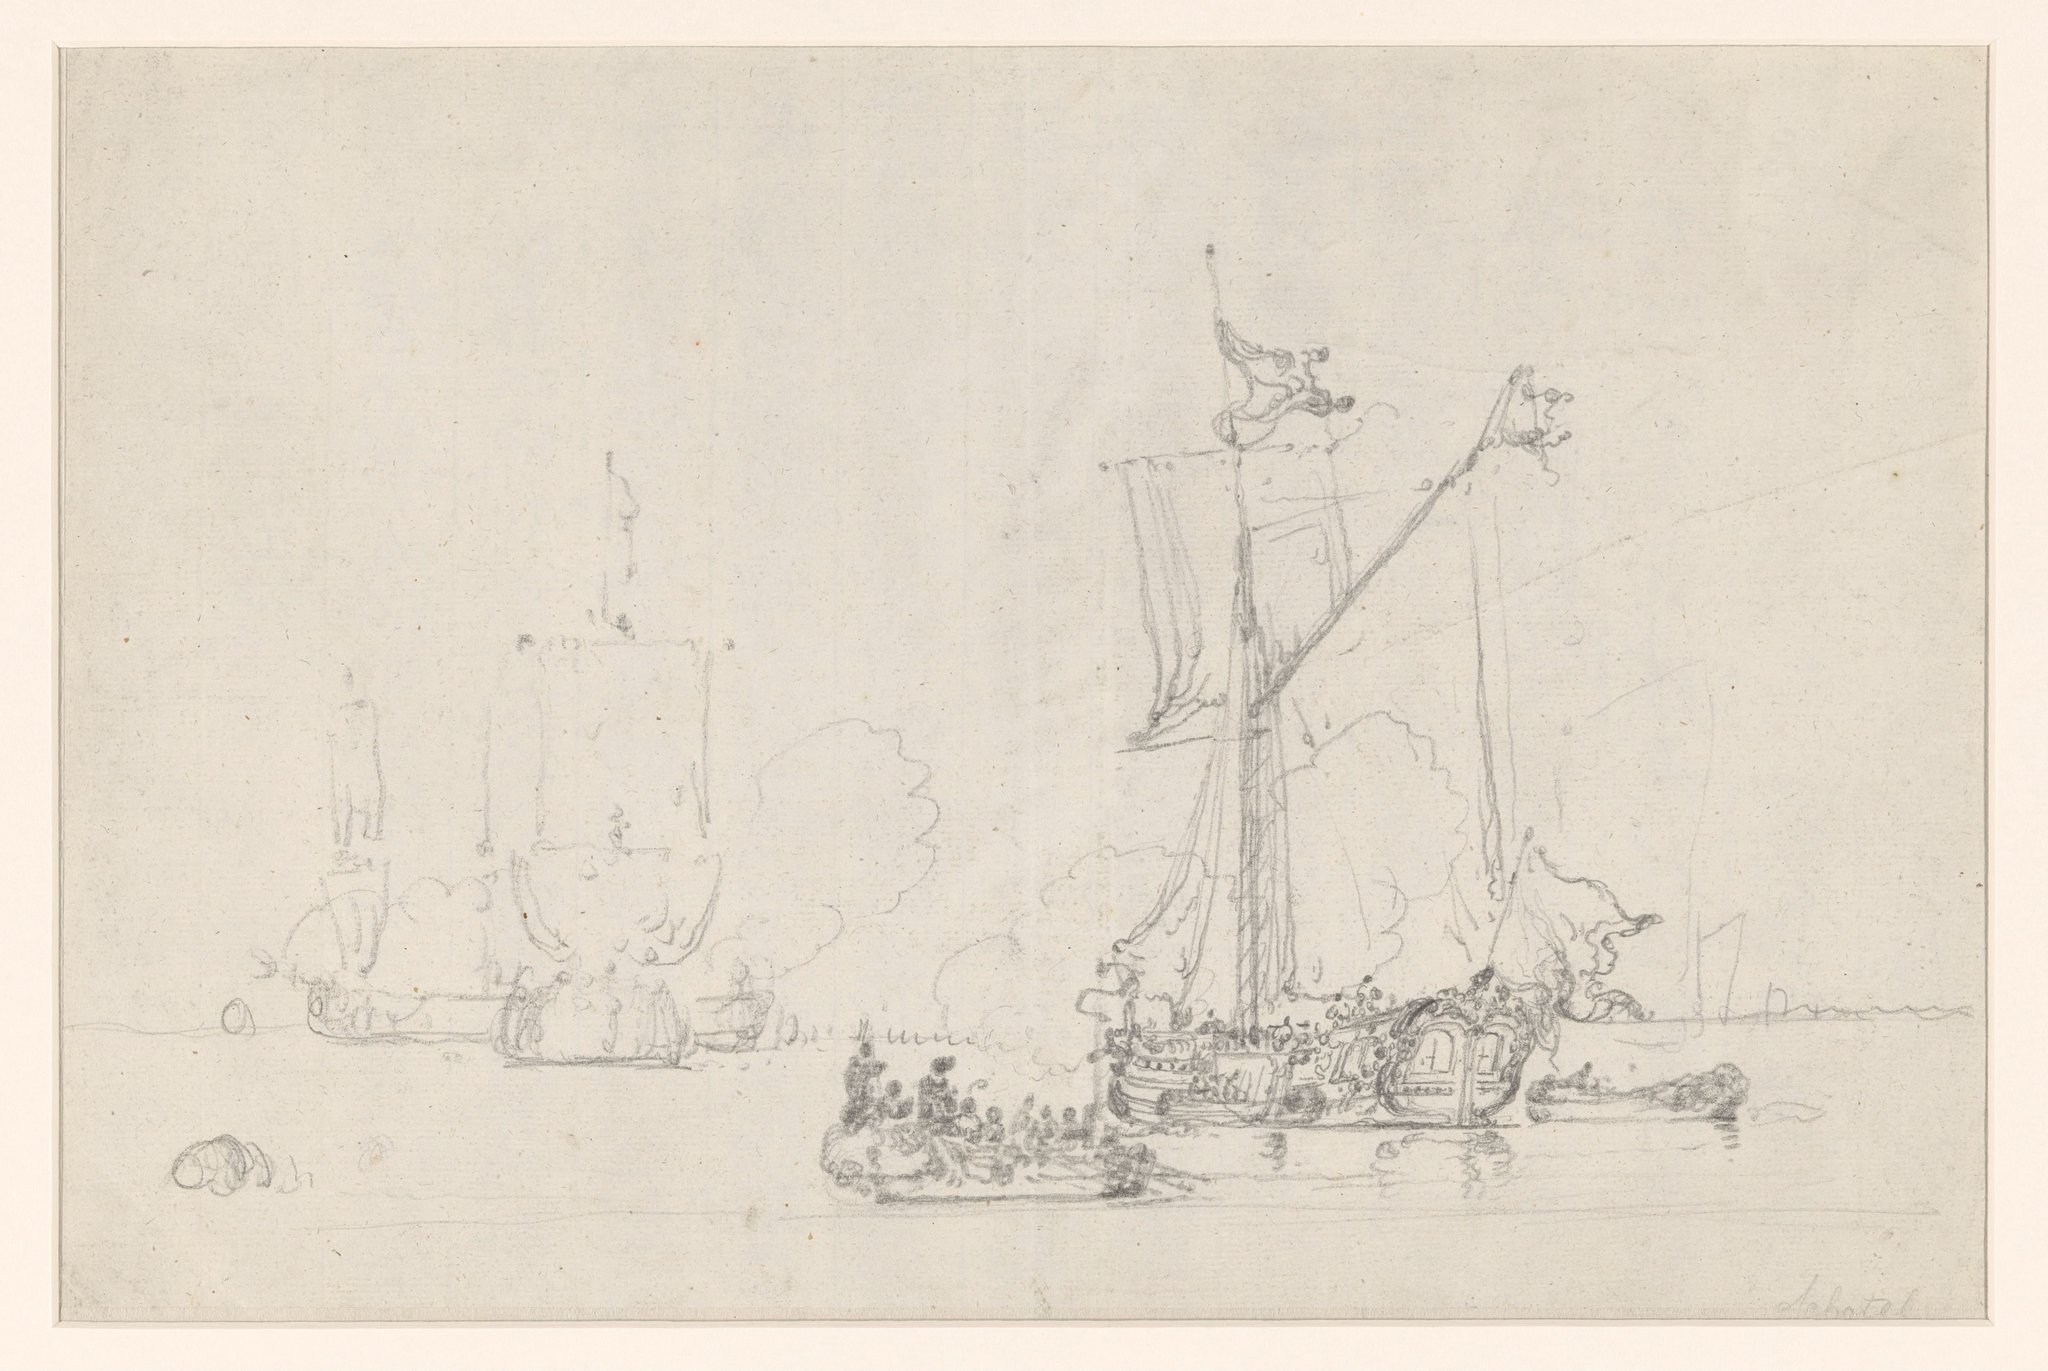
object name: drawing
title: Zeeslag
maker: johannes christiaan schotel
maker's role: draughtsman, painter, print maker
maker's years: 1787-1838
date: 1797-1838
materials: paper, pencil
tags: sailing-ship, sailing-boat, battle (+ naval force)